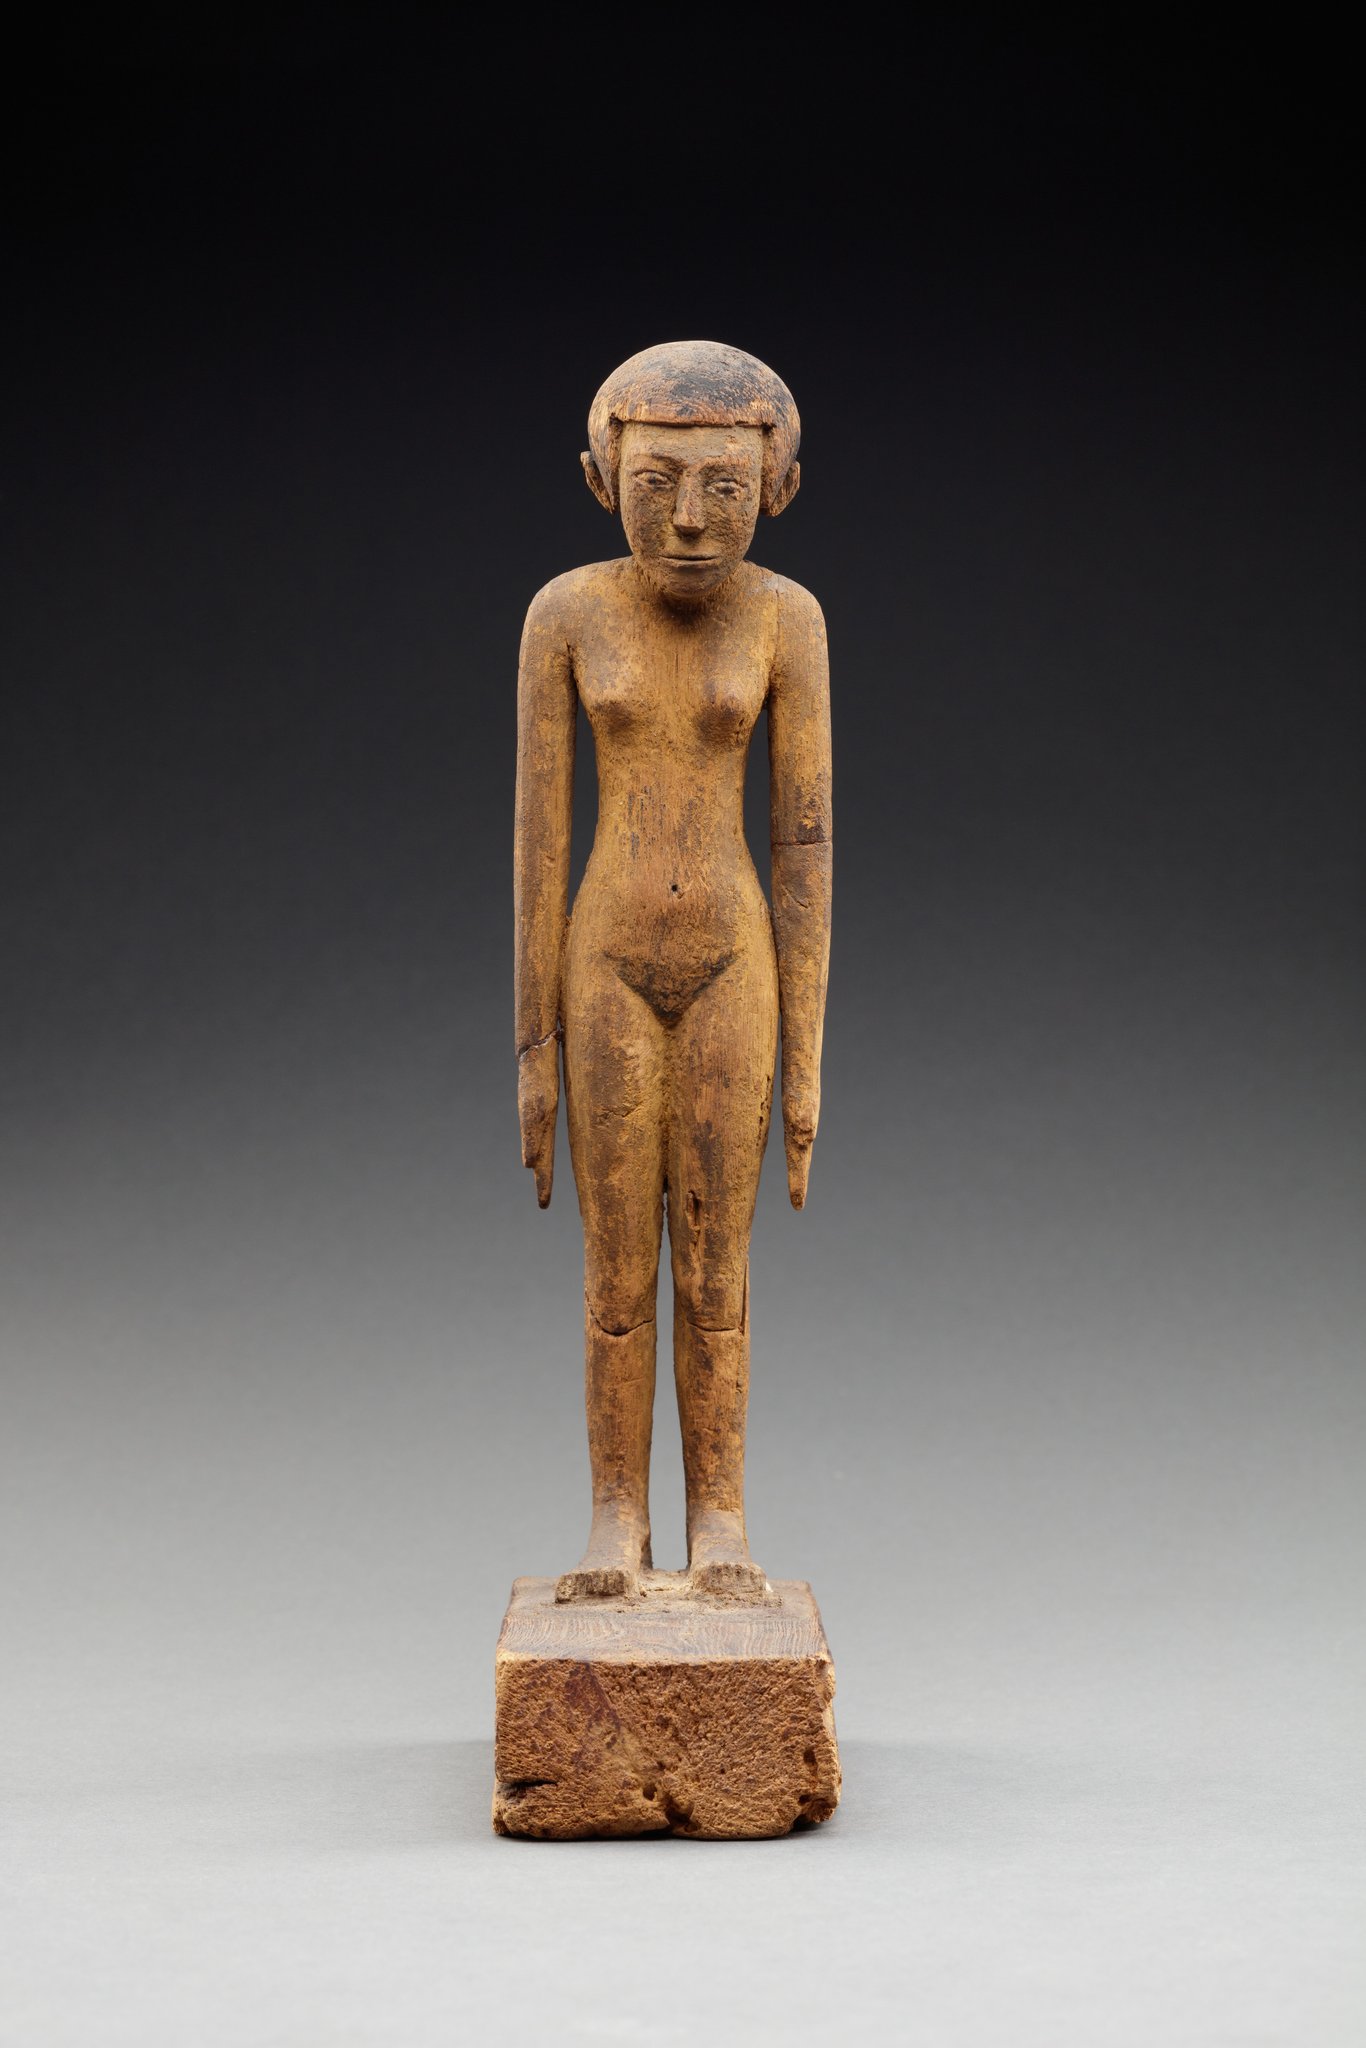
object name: statuette, female nude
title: Statuette of a Nude Woman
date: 2030-1650 BCE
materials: paint, paste, wood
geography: egypt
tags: female nudes